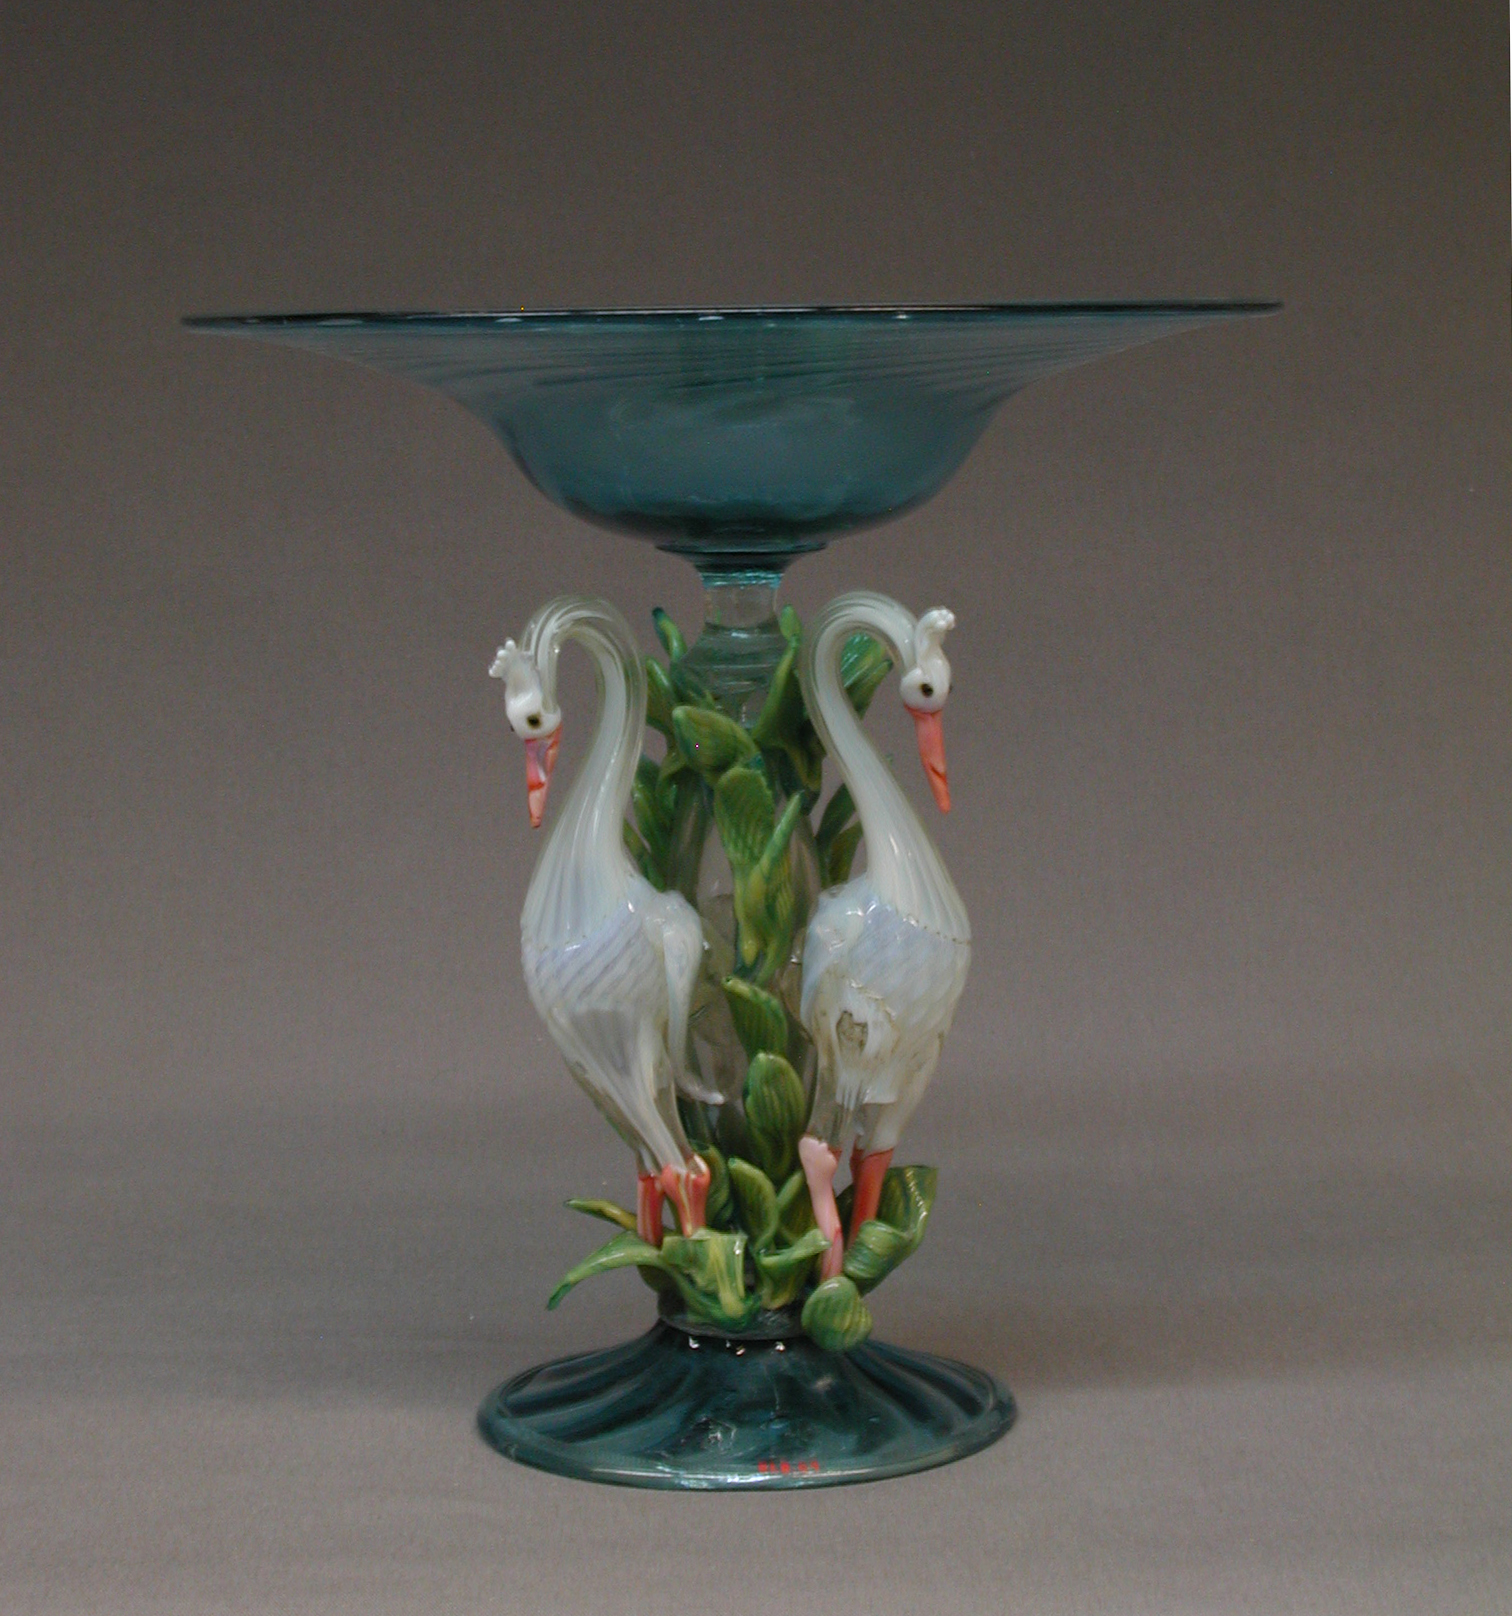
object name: tazza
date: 1801-1900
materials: glass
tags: cranes